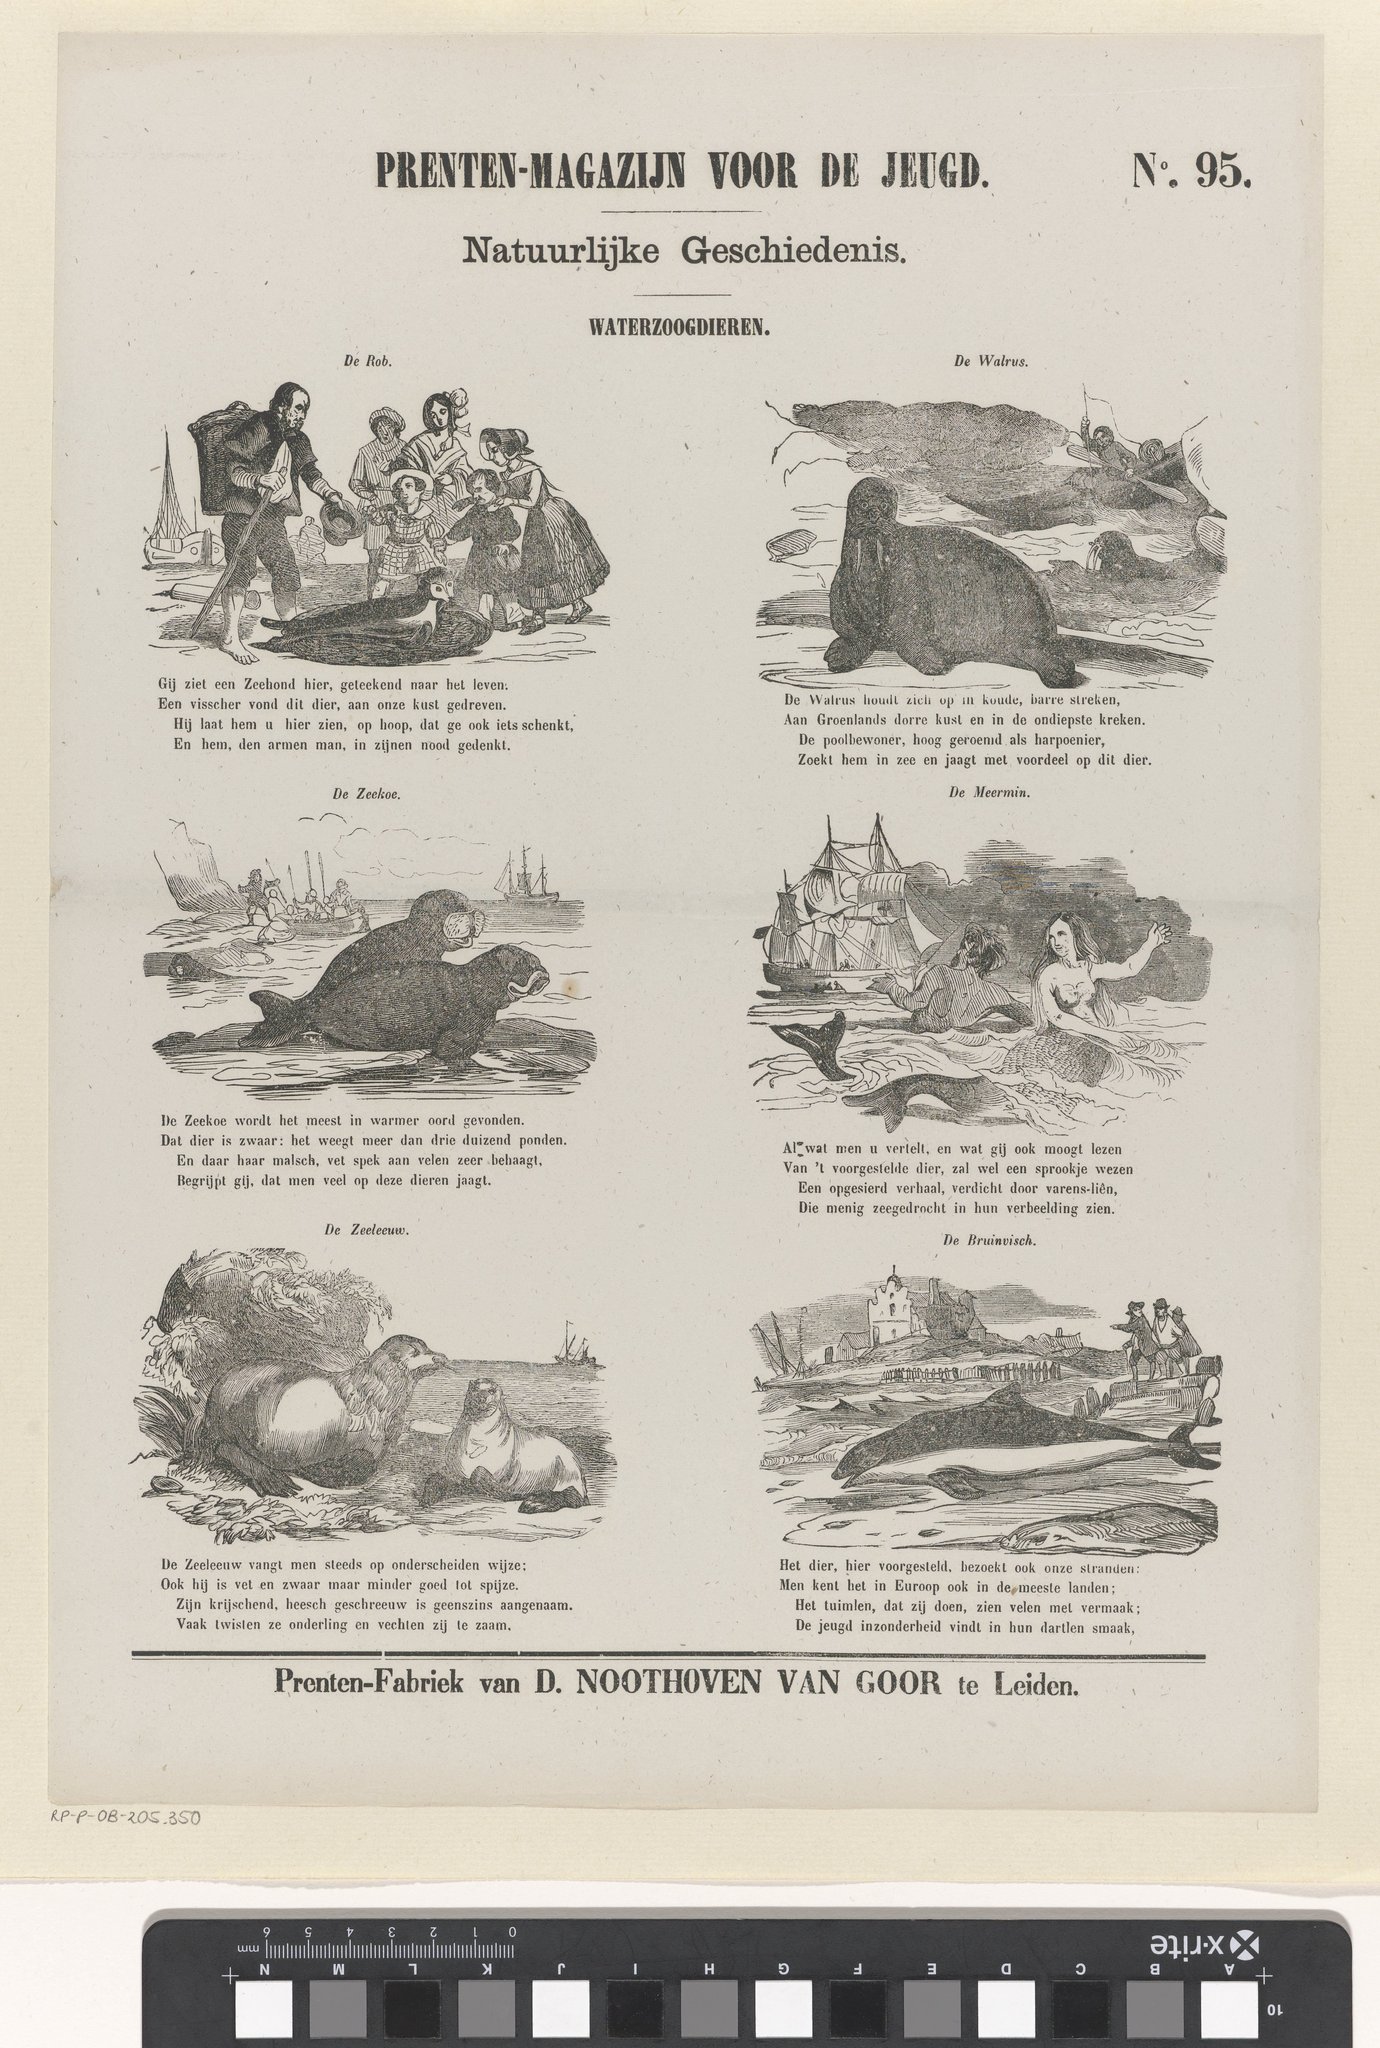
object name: print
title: Prenten-magazijn voor de jeugd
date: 1850-1881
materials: paper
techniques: letterpress printing, engraving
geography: leiden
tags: fabulous animals ~ swimming mammals, merman, merman - aa - mermaid, siren, swimming mammals: seal, swimming mammals, swimming mammals: walrus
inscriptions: collector's mark: Lugt 2760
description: Blad met 6 voorstellingen van zeezoogdieren, zoals een rob, een walrus en een zeekoe. Boven elke voorstelling een titel en onder elke voorstelling een vierregelig vers. Genummerd rechtsboven: No. 95.